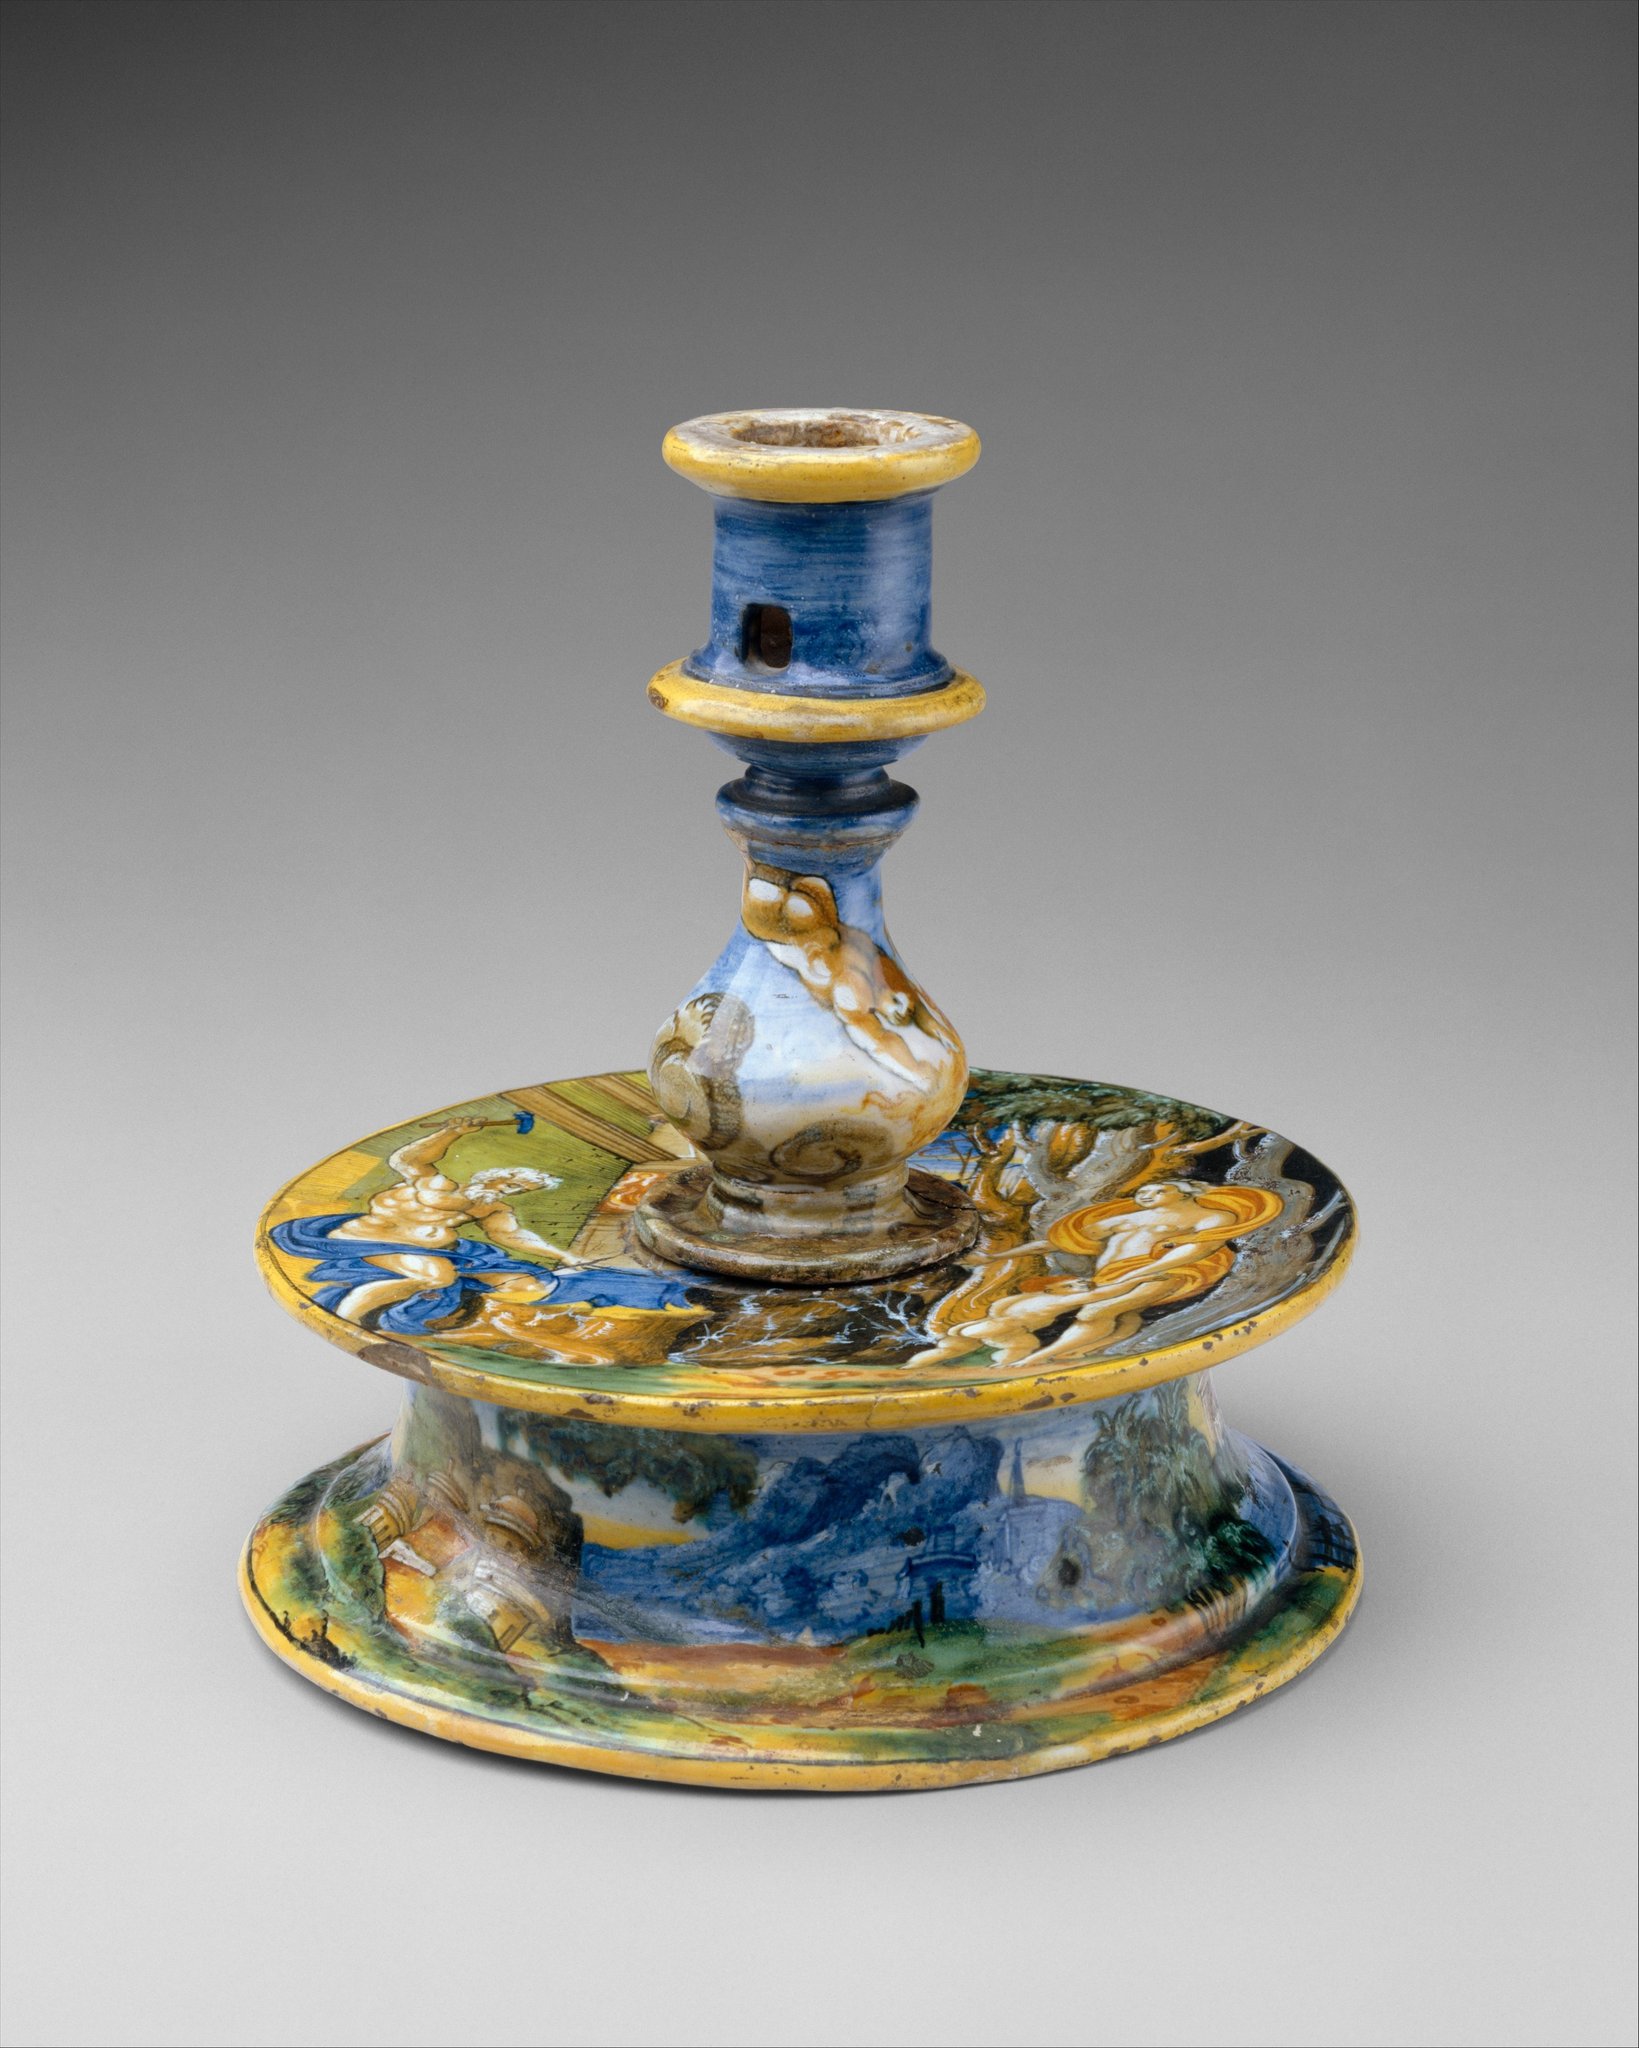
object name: candlestick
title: Candlestick (candeliere)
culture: italian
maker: workshop of guido durantino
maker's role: artist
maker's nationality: italian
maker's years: 1516-1581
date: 1535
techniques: maiolica, glazing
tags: male nudes,female nudes,cupid,venus